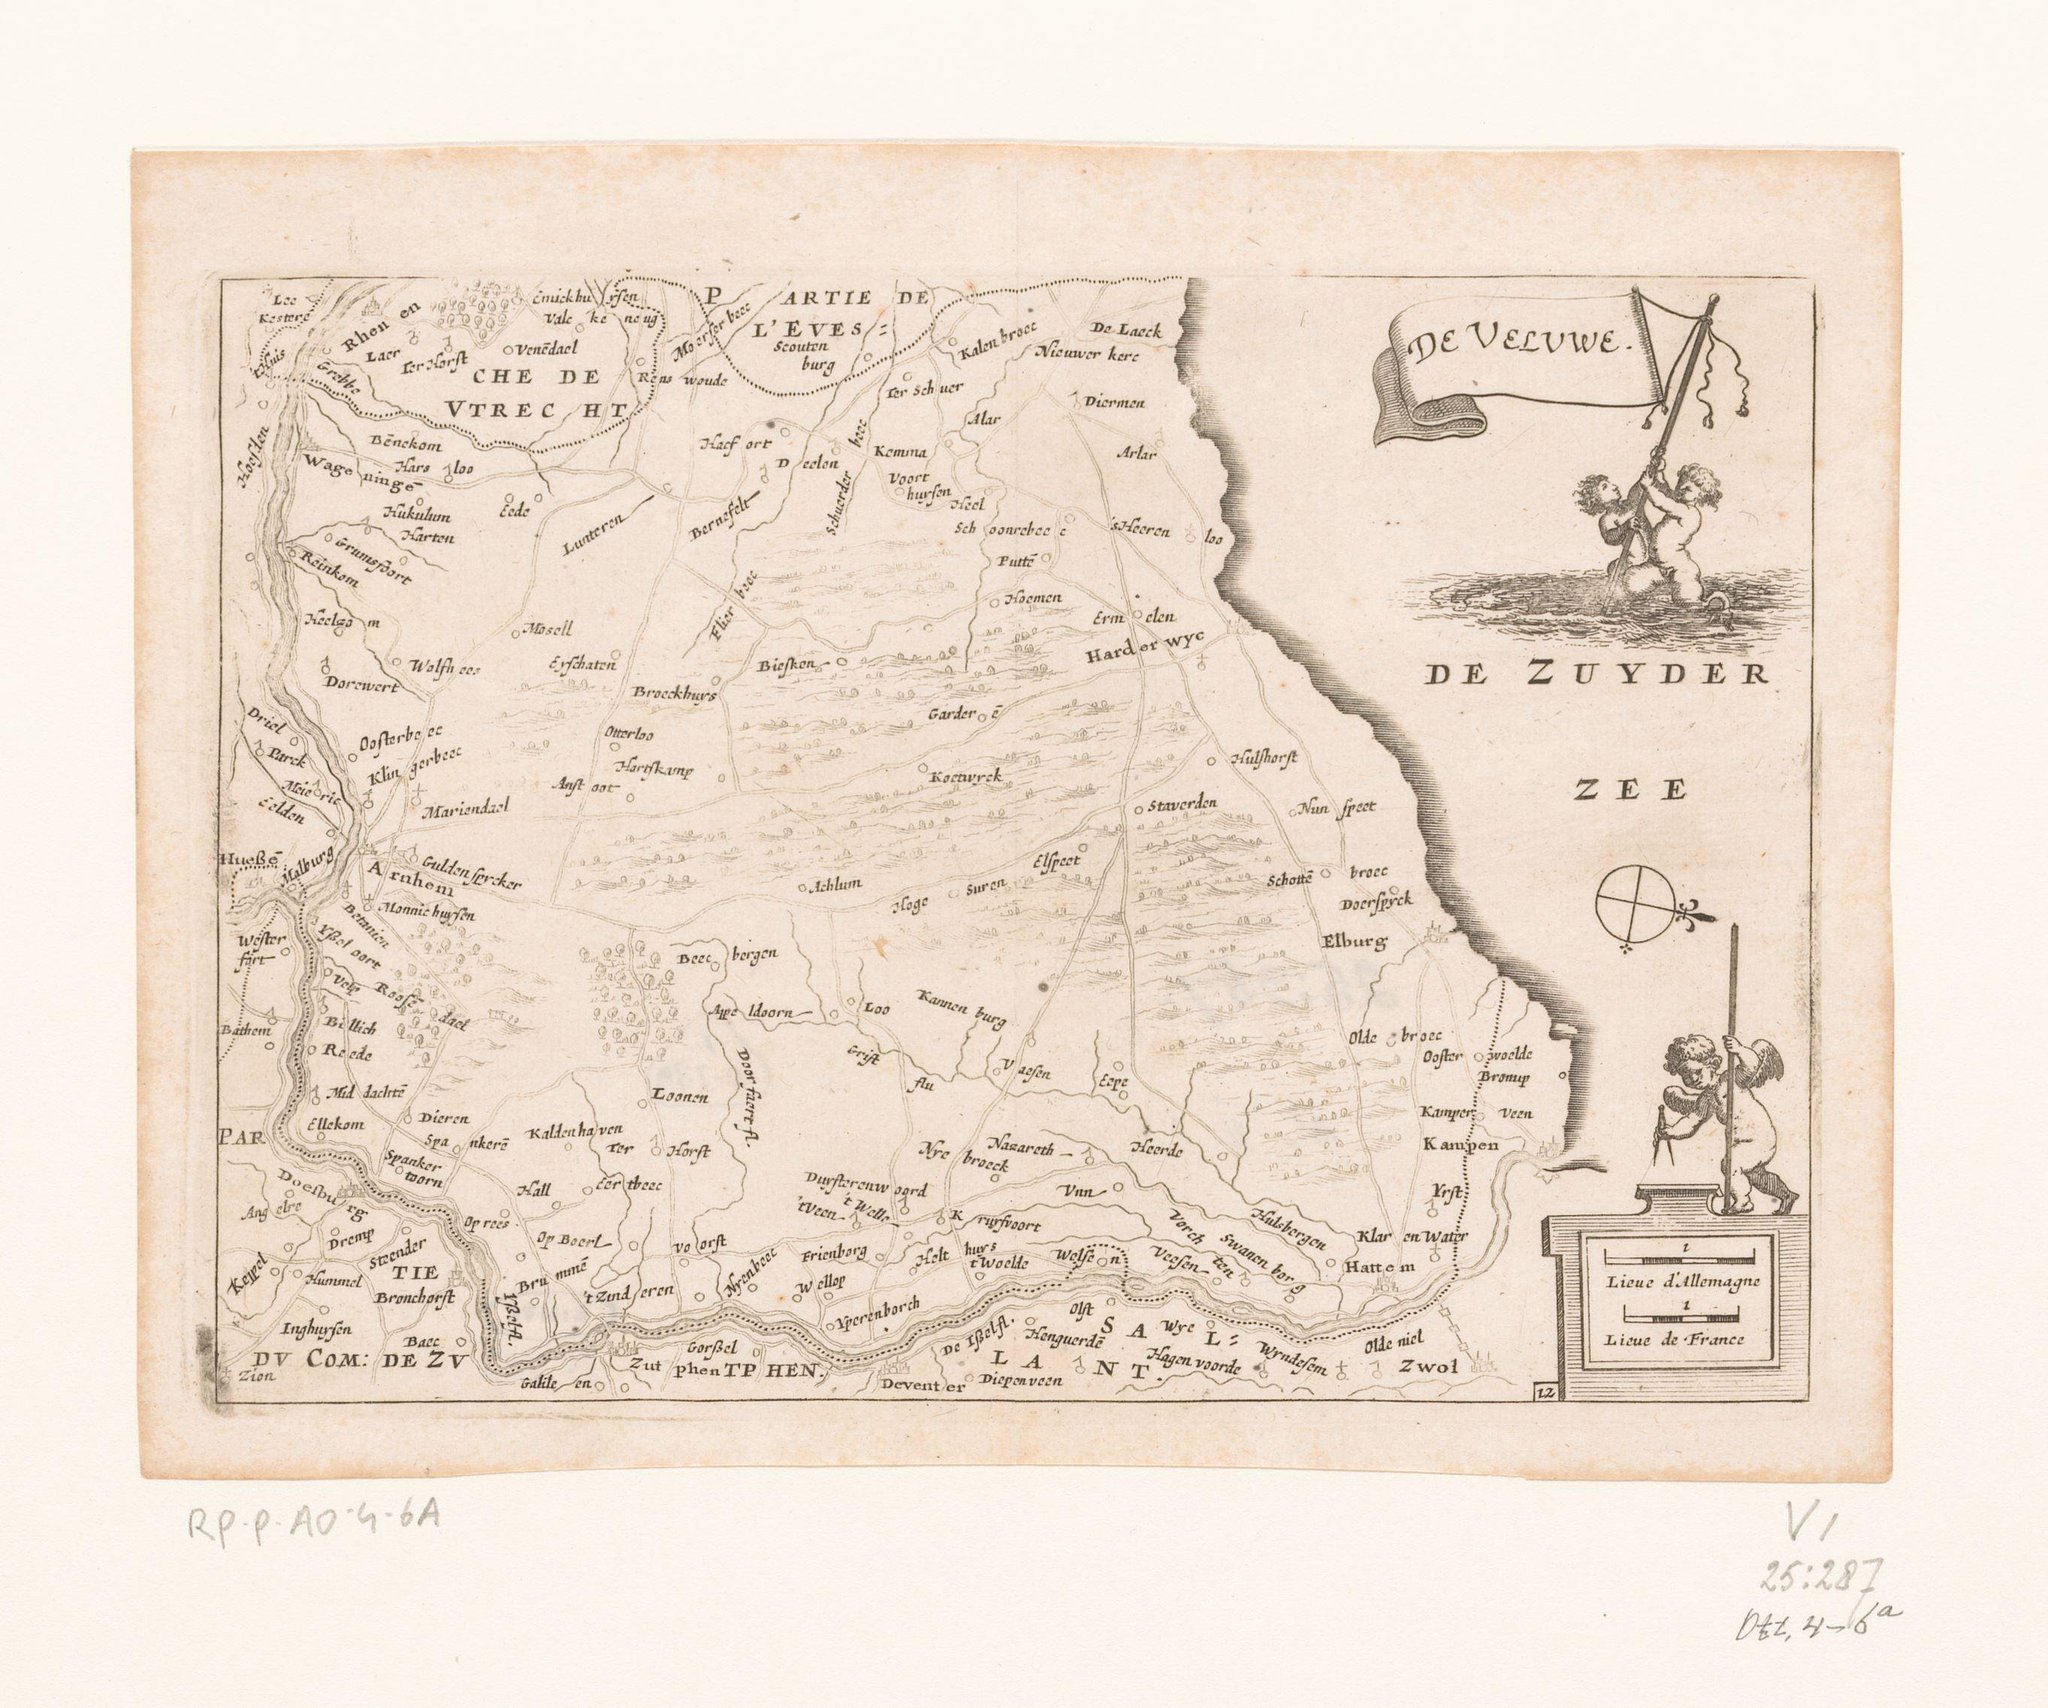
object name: map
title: Kaart van de Veluwe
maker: Anonymous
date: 1635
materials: paper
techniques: engraving, etching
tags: maps of separate countries or regions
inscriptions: collector's mark: Lugt 2228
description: Deze staat van prent ook gebruikt in: De vyerighe colom klaer vertoonende in vyftich onderscheydene curieuse caarten de XVII. Nederlantsche Provincien (…). Amsterdam: Jacob Aertsz Colom (I), s.a. [ca. 1660]. En in latere uitgaven met de platen van deze publicatie, uitgegeven door Pieter van Alphen (1691) en Pieter van der Slaart (1696). Eerdere staat van prent (zonder '10' rechtsonder) ook gebruikt in eerdere drukken van deze publicatie